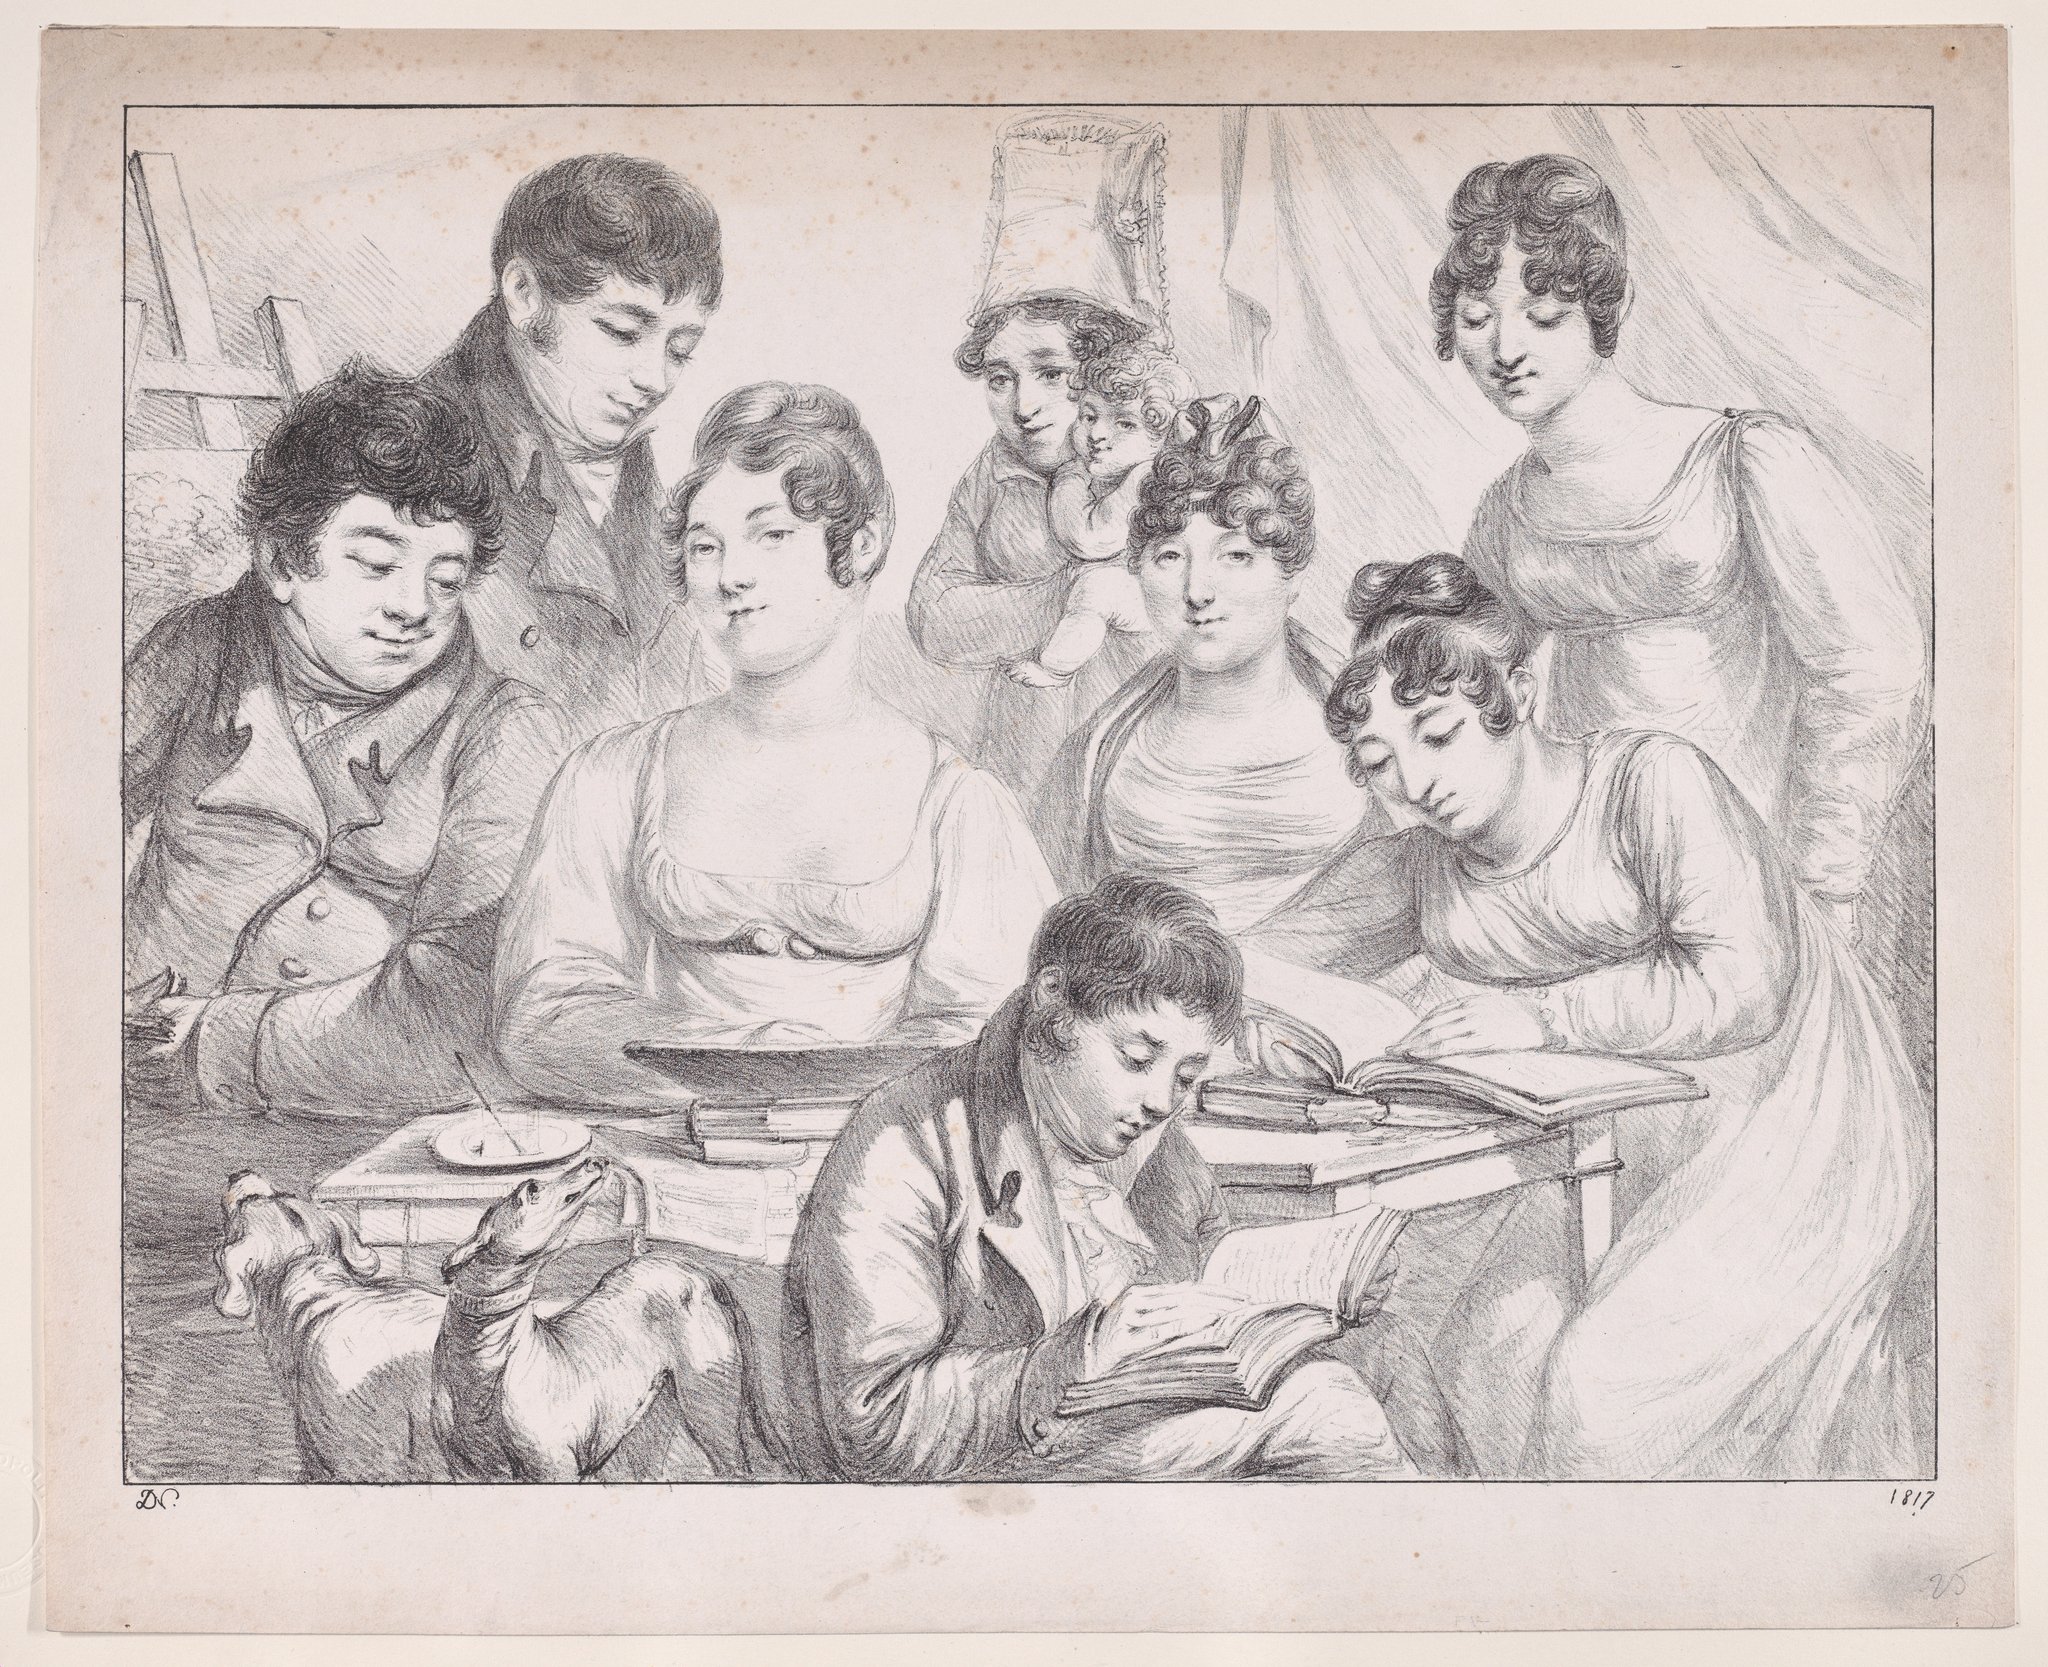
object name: print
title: La Famille Denon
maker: baron dominique vivant denon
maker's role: artist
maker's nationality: french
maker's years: 1747-1825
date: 1817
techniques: lithograph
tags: books,infants,men,women,reading,dogs